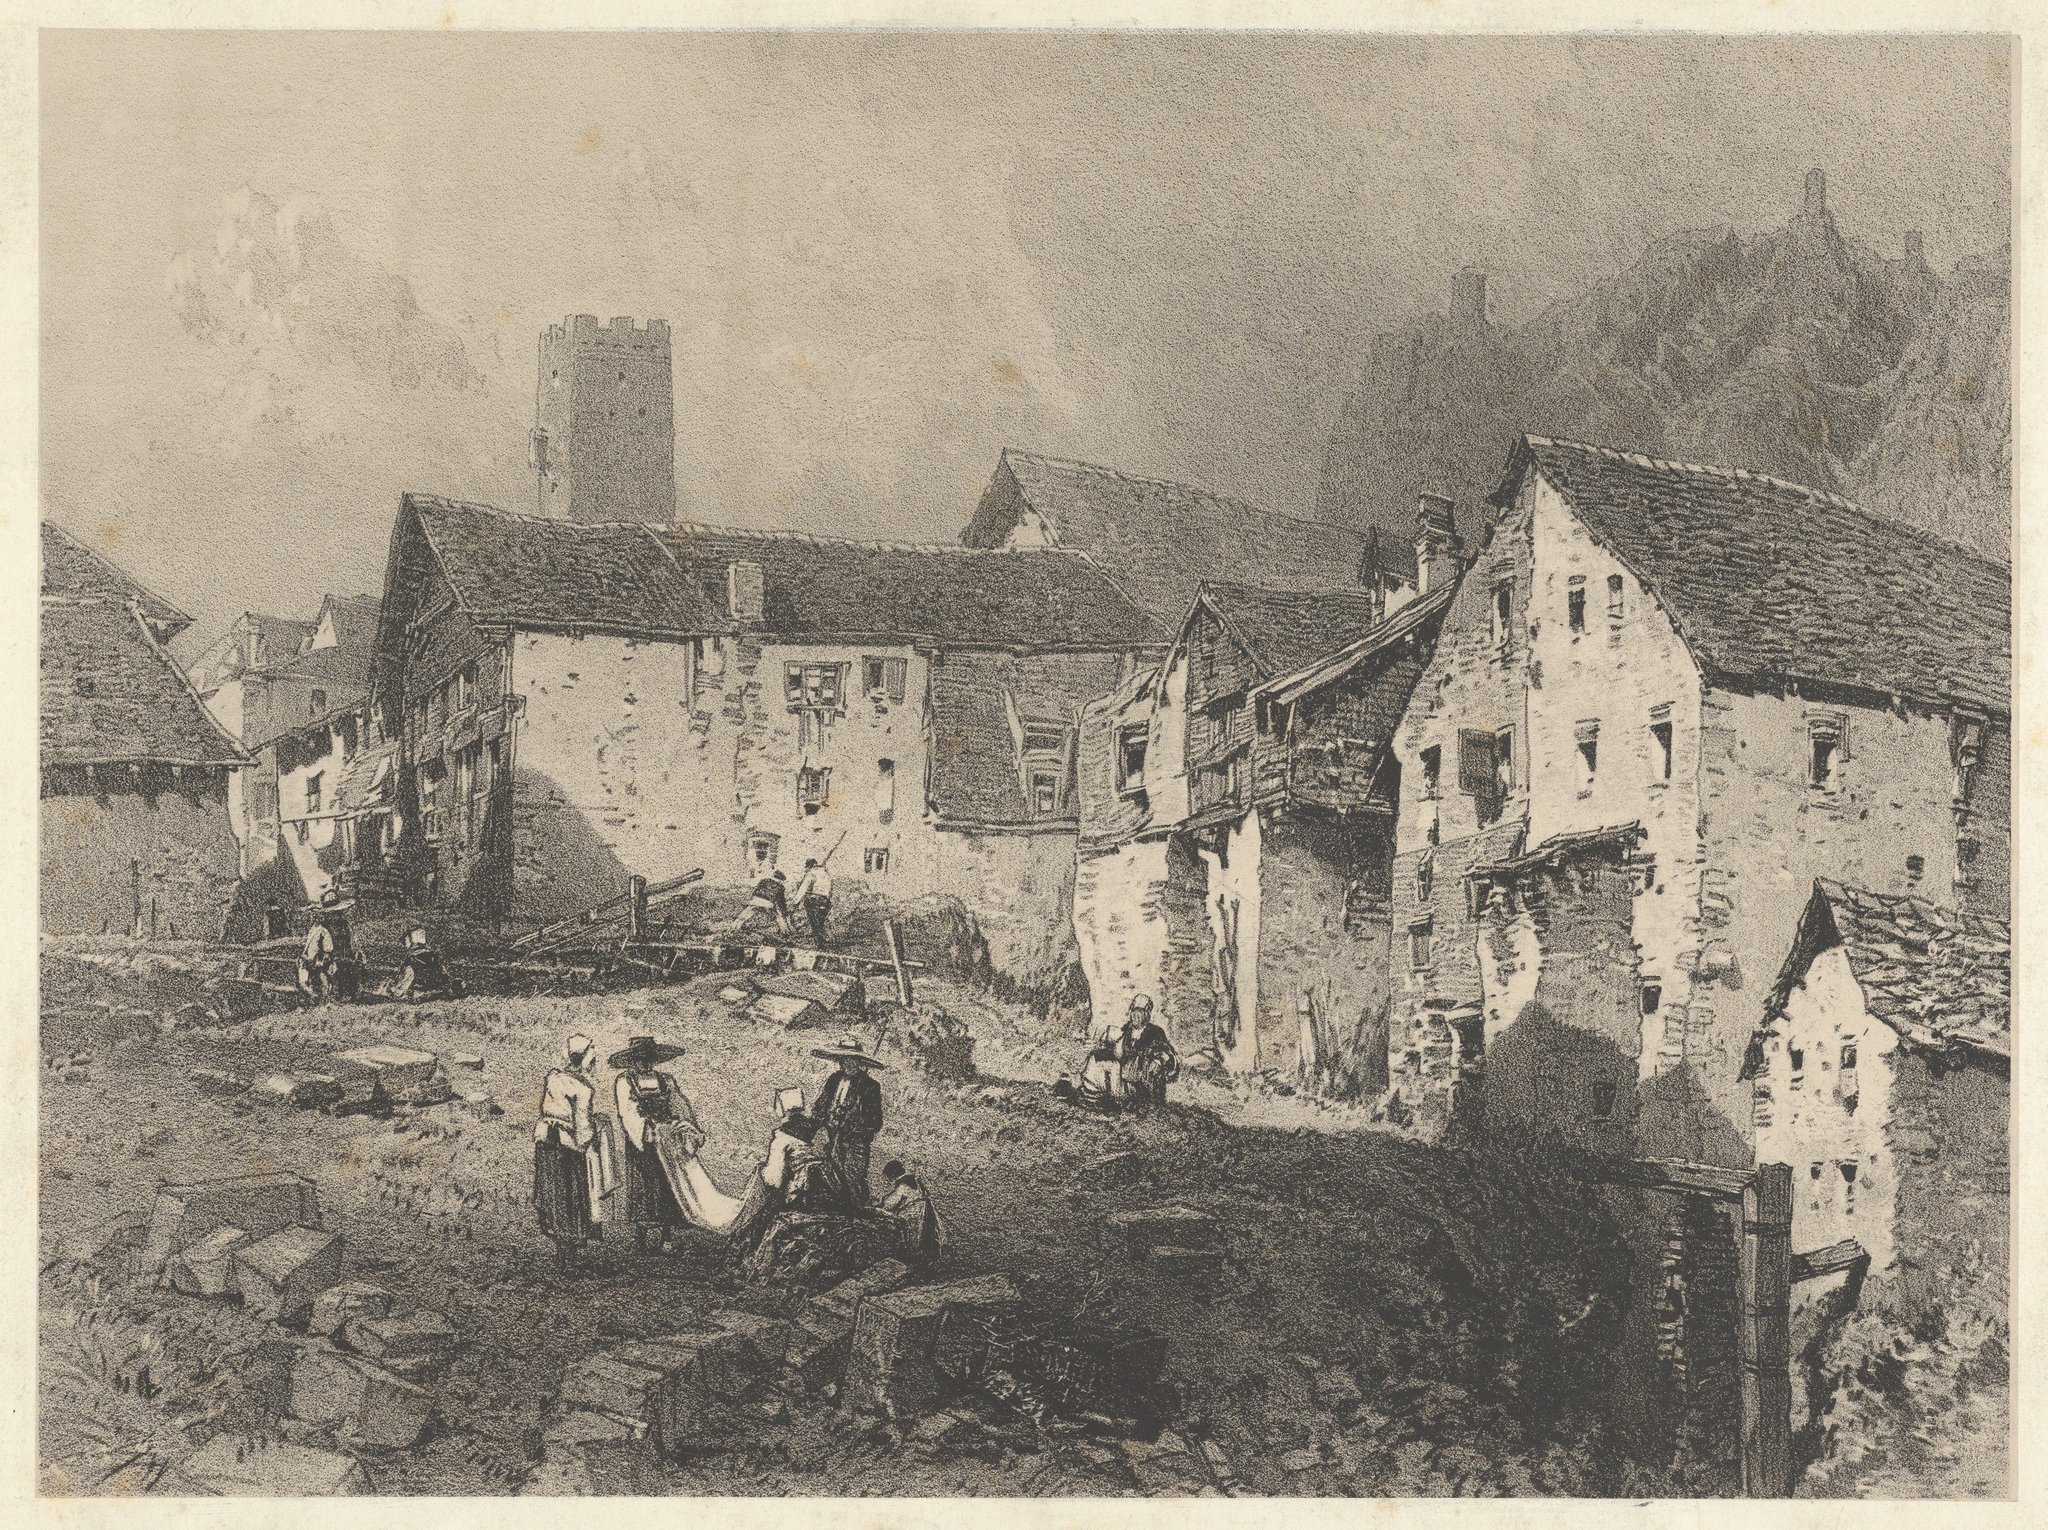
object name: print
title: View of a Mountain Village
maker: eugène isabey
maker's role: artist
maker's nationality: french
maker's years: 1803-1886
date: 1829-1833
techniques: printmaking, lithograph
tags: human figures,villages,mountains